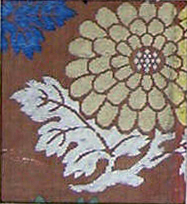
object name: piece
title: Textile with Partial Chrysanthemum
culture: japanese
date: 1615-1868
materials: silk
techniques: brocade, weave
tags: flowers